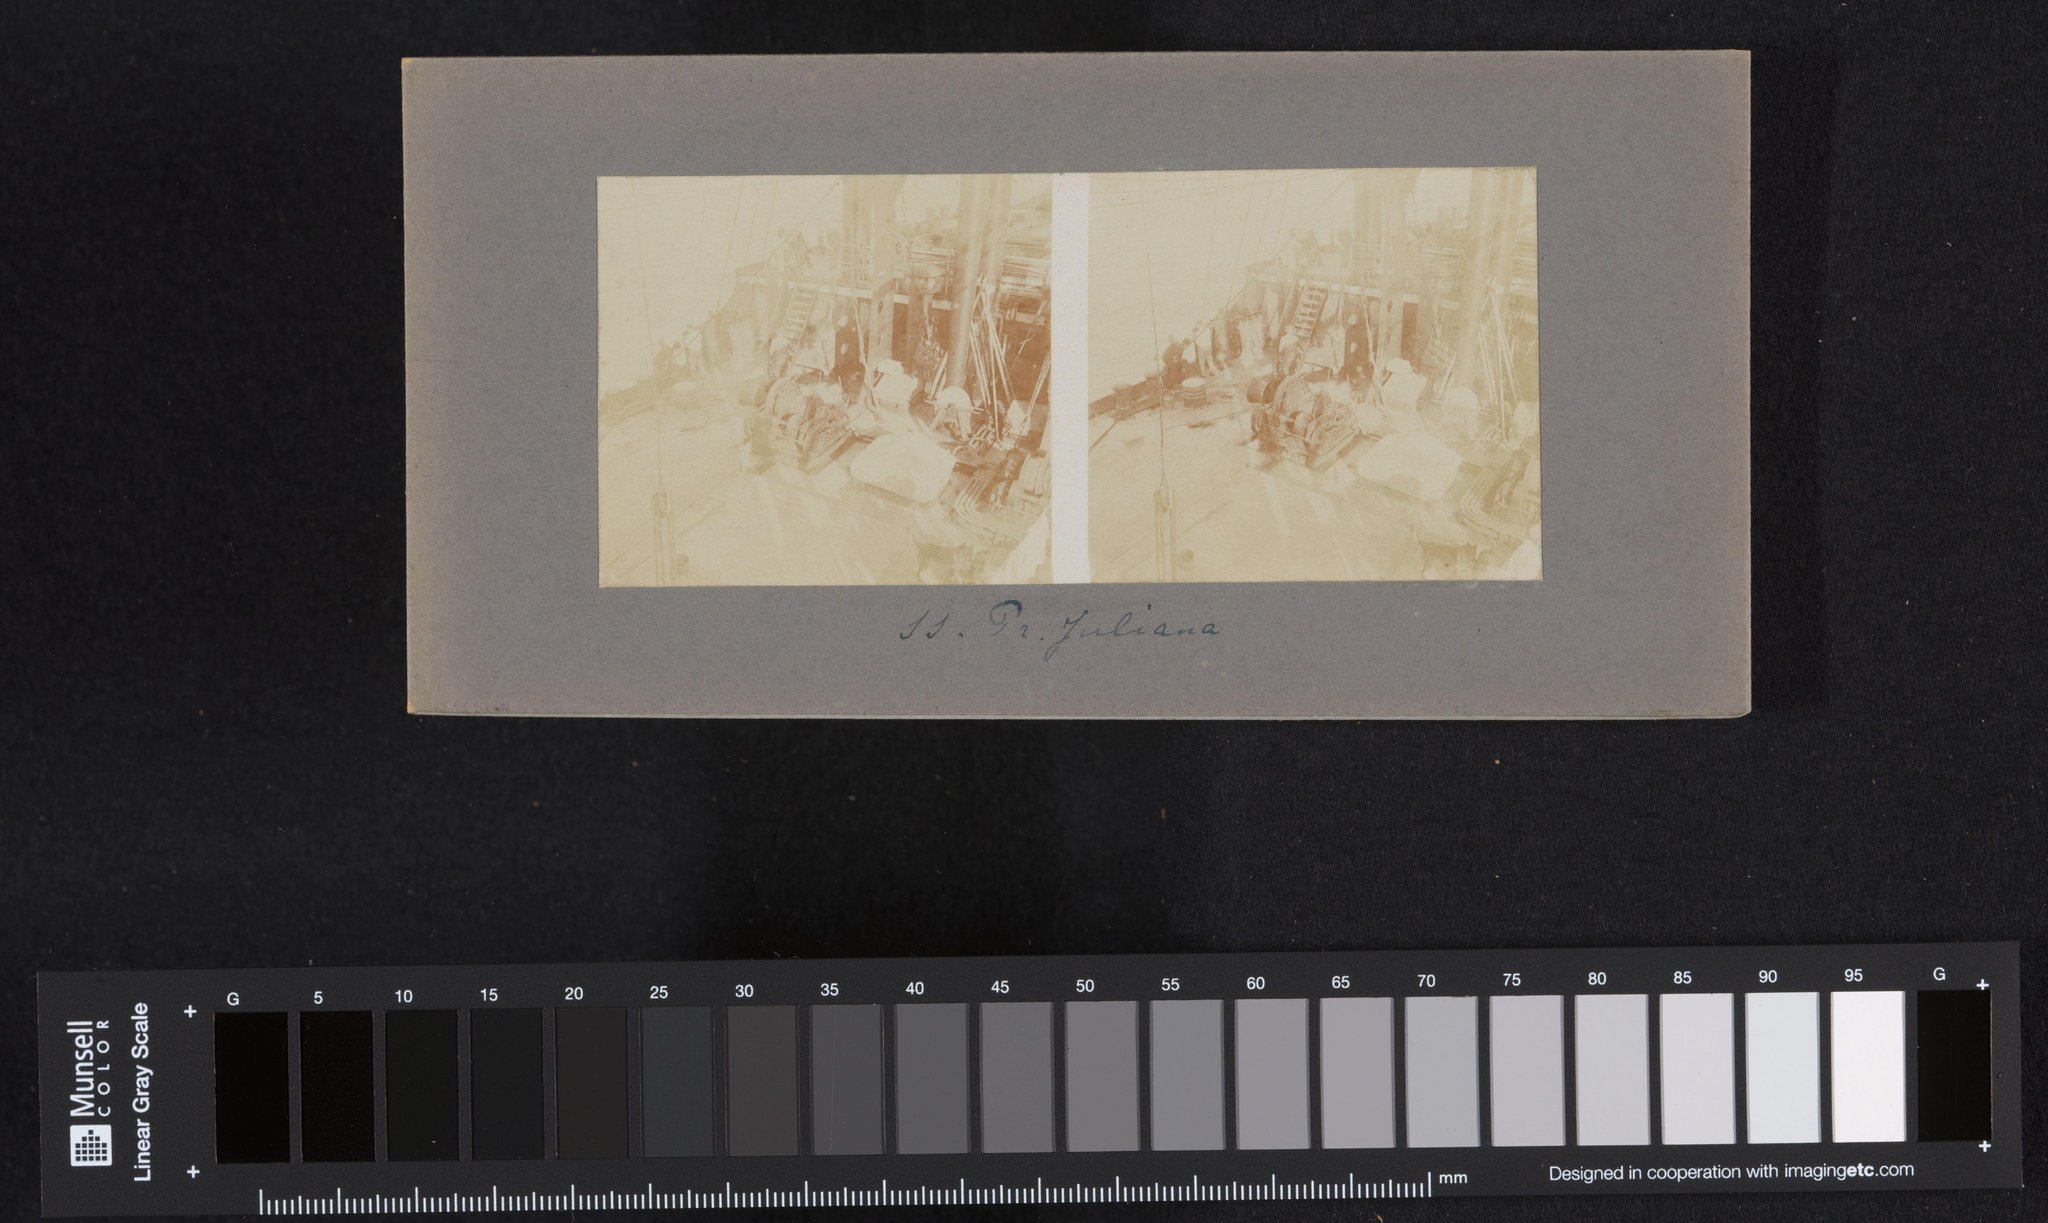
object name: stereograph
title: Aan boord van de Prinses Juliana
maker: robert julius boers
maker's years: 1867-1932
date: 1903-1914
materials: cardboard, photographic support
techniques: gelatin silver print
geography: dutch east indies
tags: robert julius boers, dutch east indies, the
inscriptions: inscription: ‘Voorschip ss. Prinses Juliana" Maart 1914’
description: Gezicht op het voorschip van de S.S. Prinses Juliana, maart 1914. Onderdeel van een groep stereofoto's van Robert Julius Boers, chef van het staatsbedrijf de Banka-tinwinning op Banka, uit de periode ca. 1900-1922.